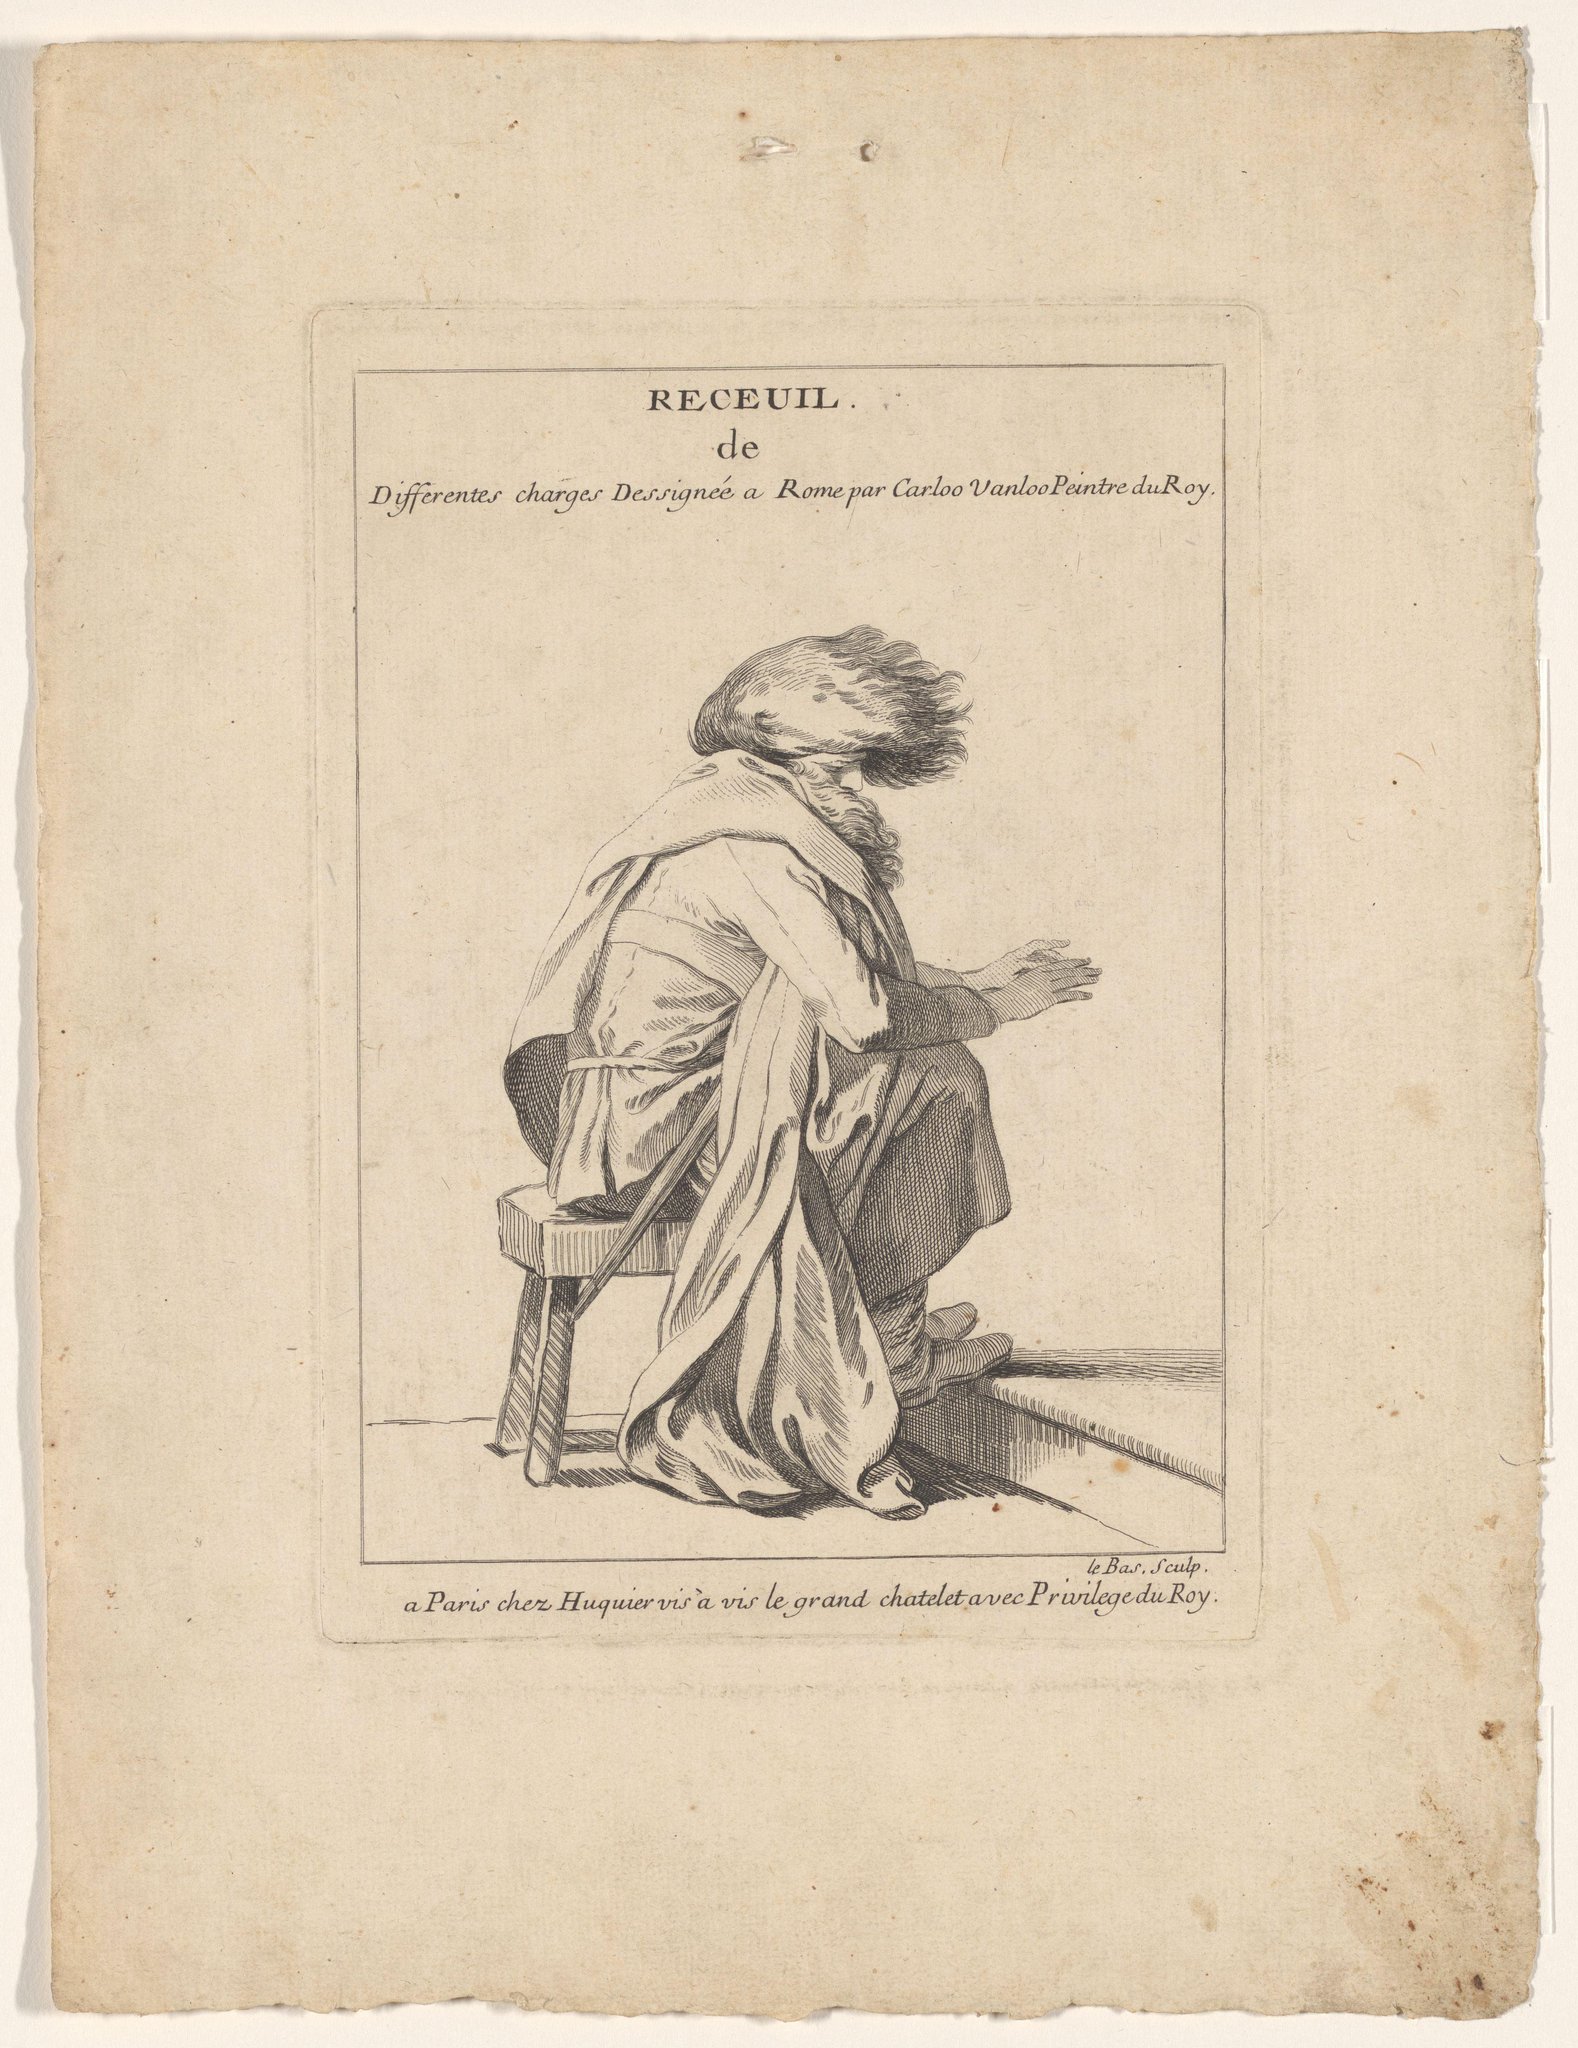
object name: print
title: Verzameling van verschillende gedramatiseerde poses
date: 1732-1740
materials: paper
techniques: etching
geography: paris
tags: passions, emotions, affections, asiatic races and peoples (+ costume), characters (human types), actor (on the stage)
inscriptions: collector's mark: Lugt 2760, collector's mark: Lugt 2228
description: Man in lang gewaad, zittend op een kruk met wapperend haar en uitgestoken handen. Ongenummerd. Titelprent voor de serie van twaalf prenten met figuren in gedramatiseerde poses, veelal gekleed in ‘Oosterse’ fantasiekostuums, naar tekeningen van Carle van Loo, gemaakt tijdens zijn verblijf in Rome (1728-1732).